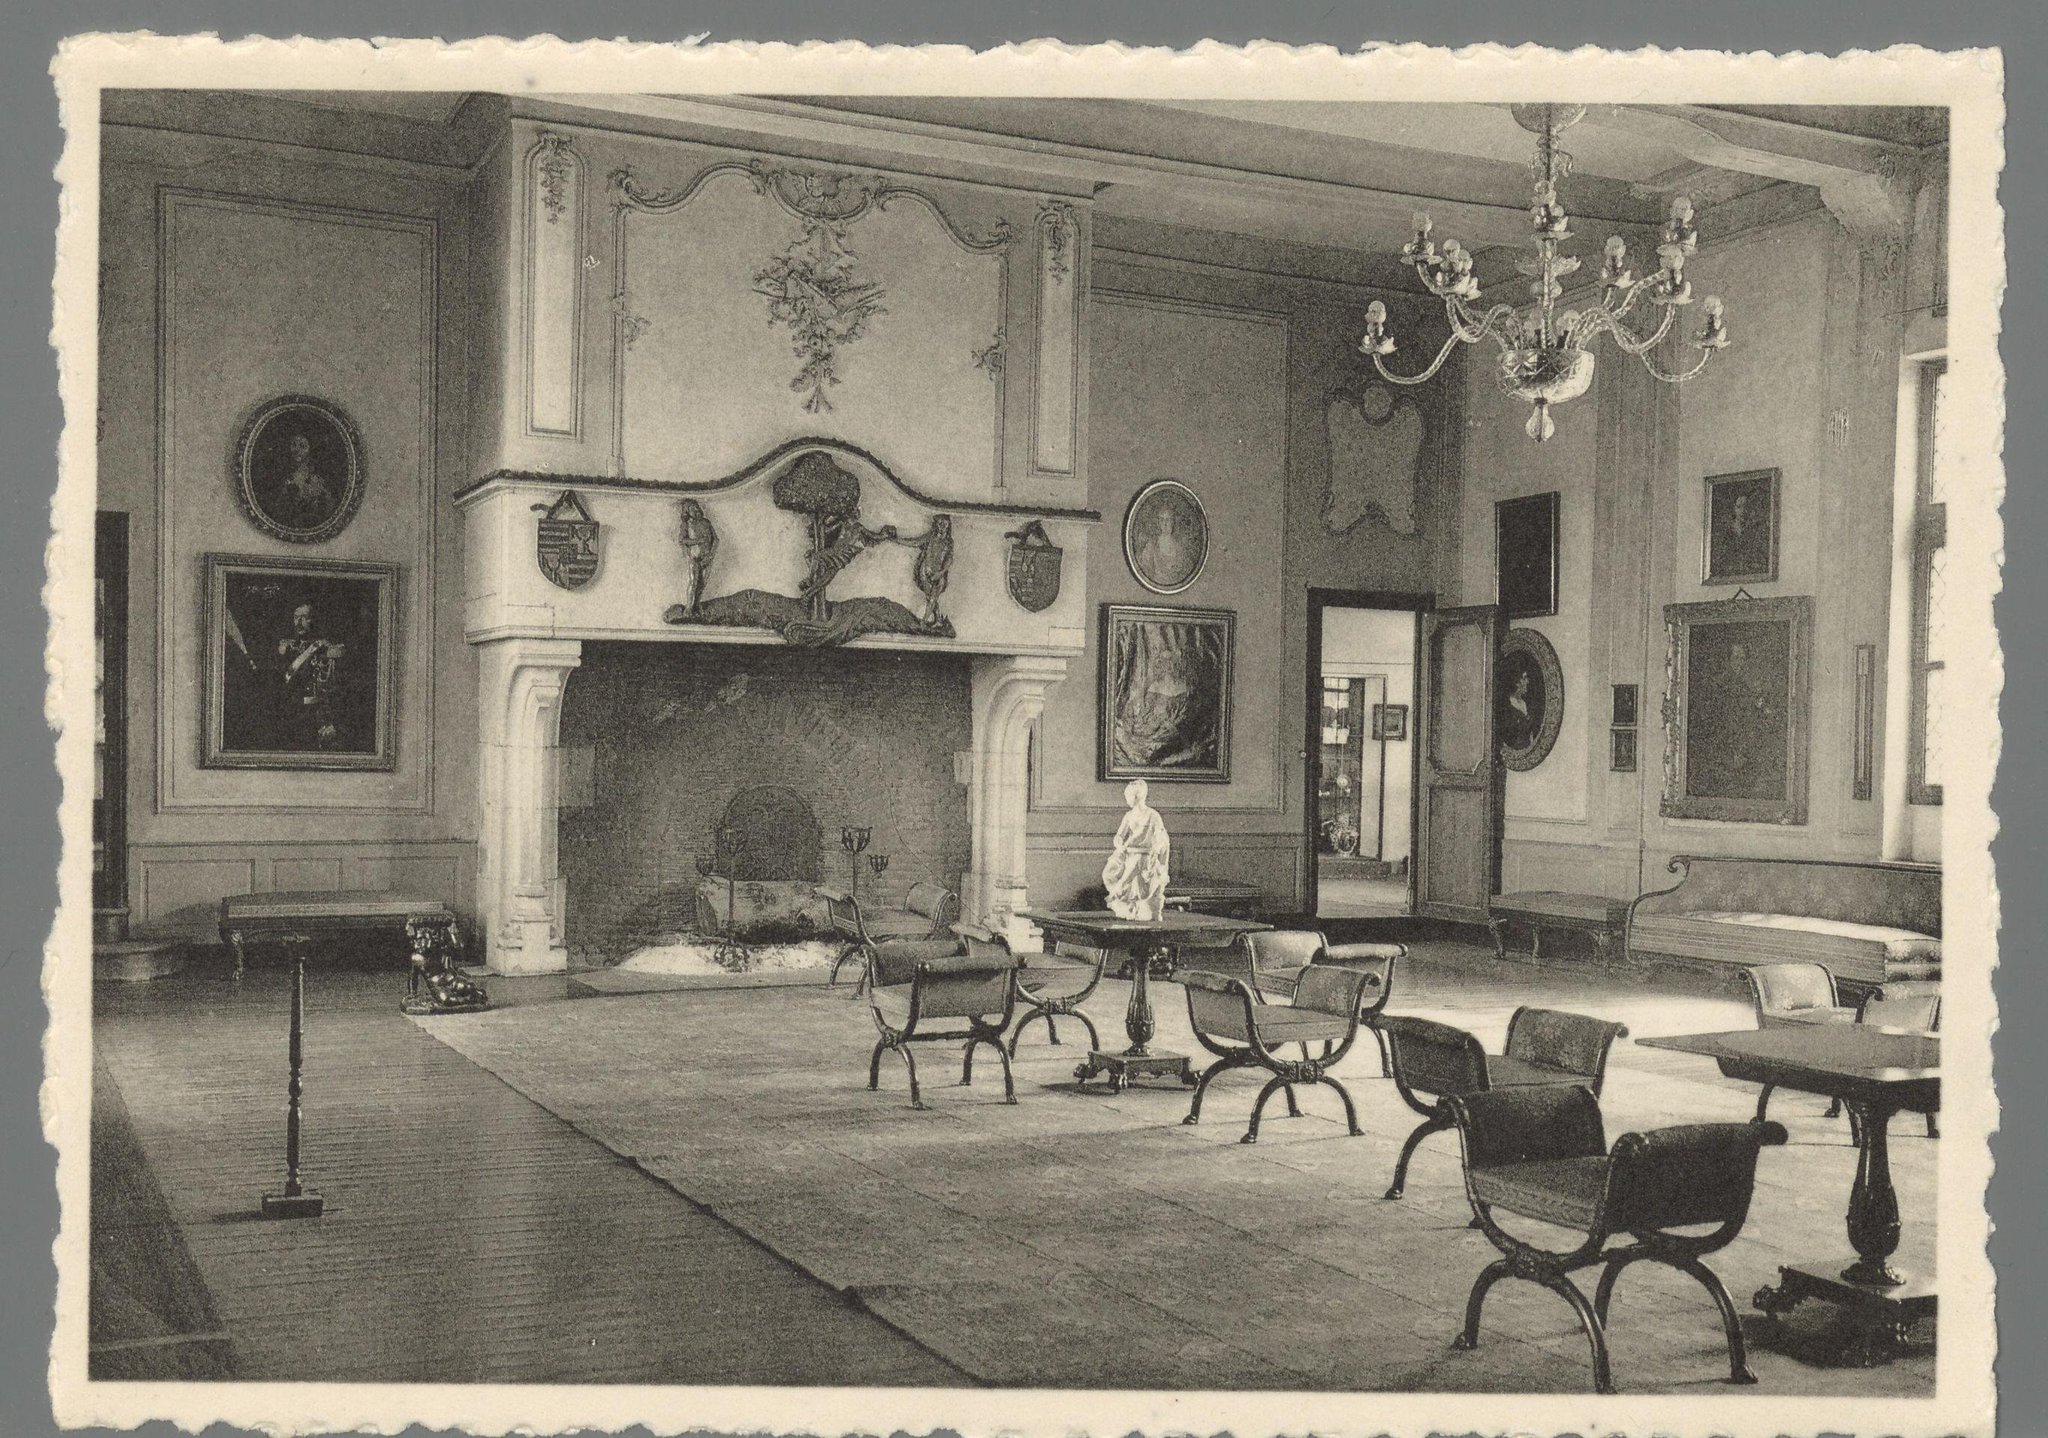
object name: photomechanical print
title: Château d'Ecausinnes-Lalaing (XIVe siècle)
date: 1913-1950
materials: cardboard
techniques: photograph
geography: brussels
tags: castle, permanent exhibition, museum, interior ~ representation of a building